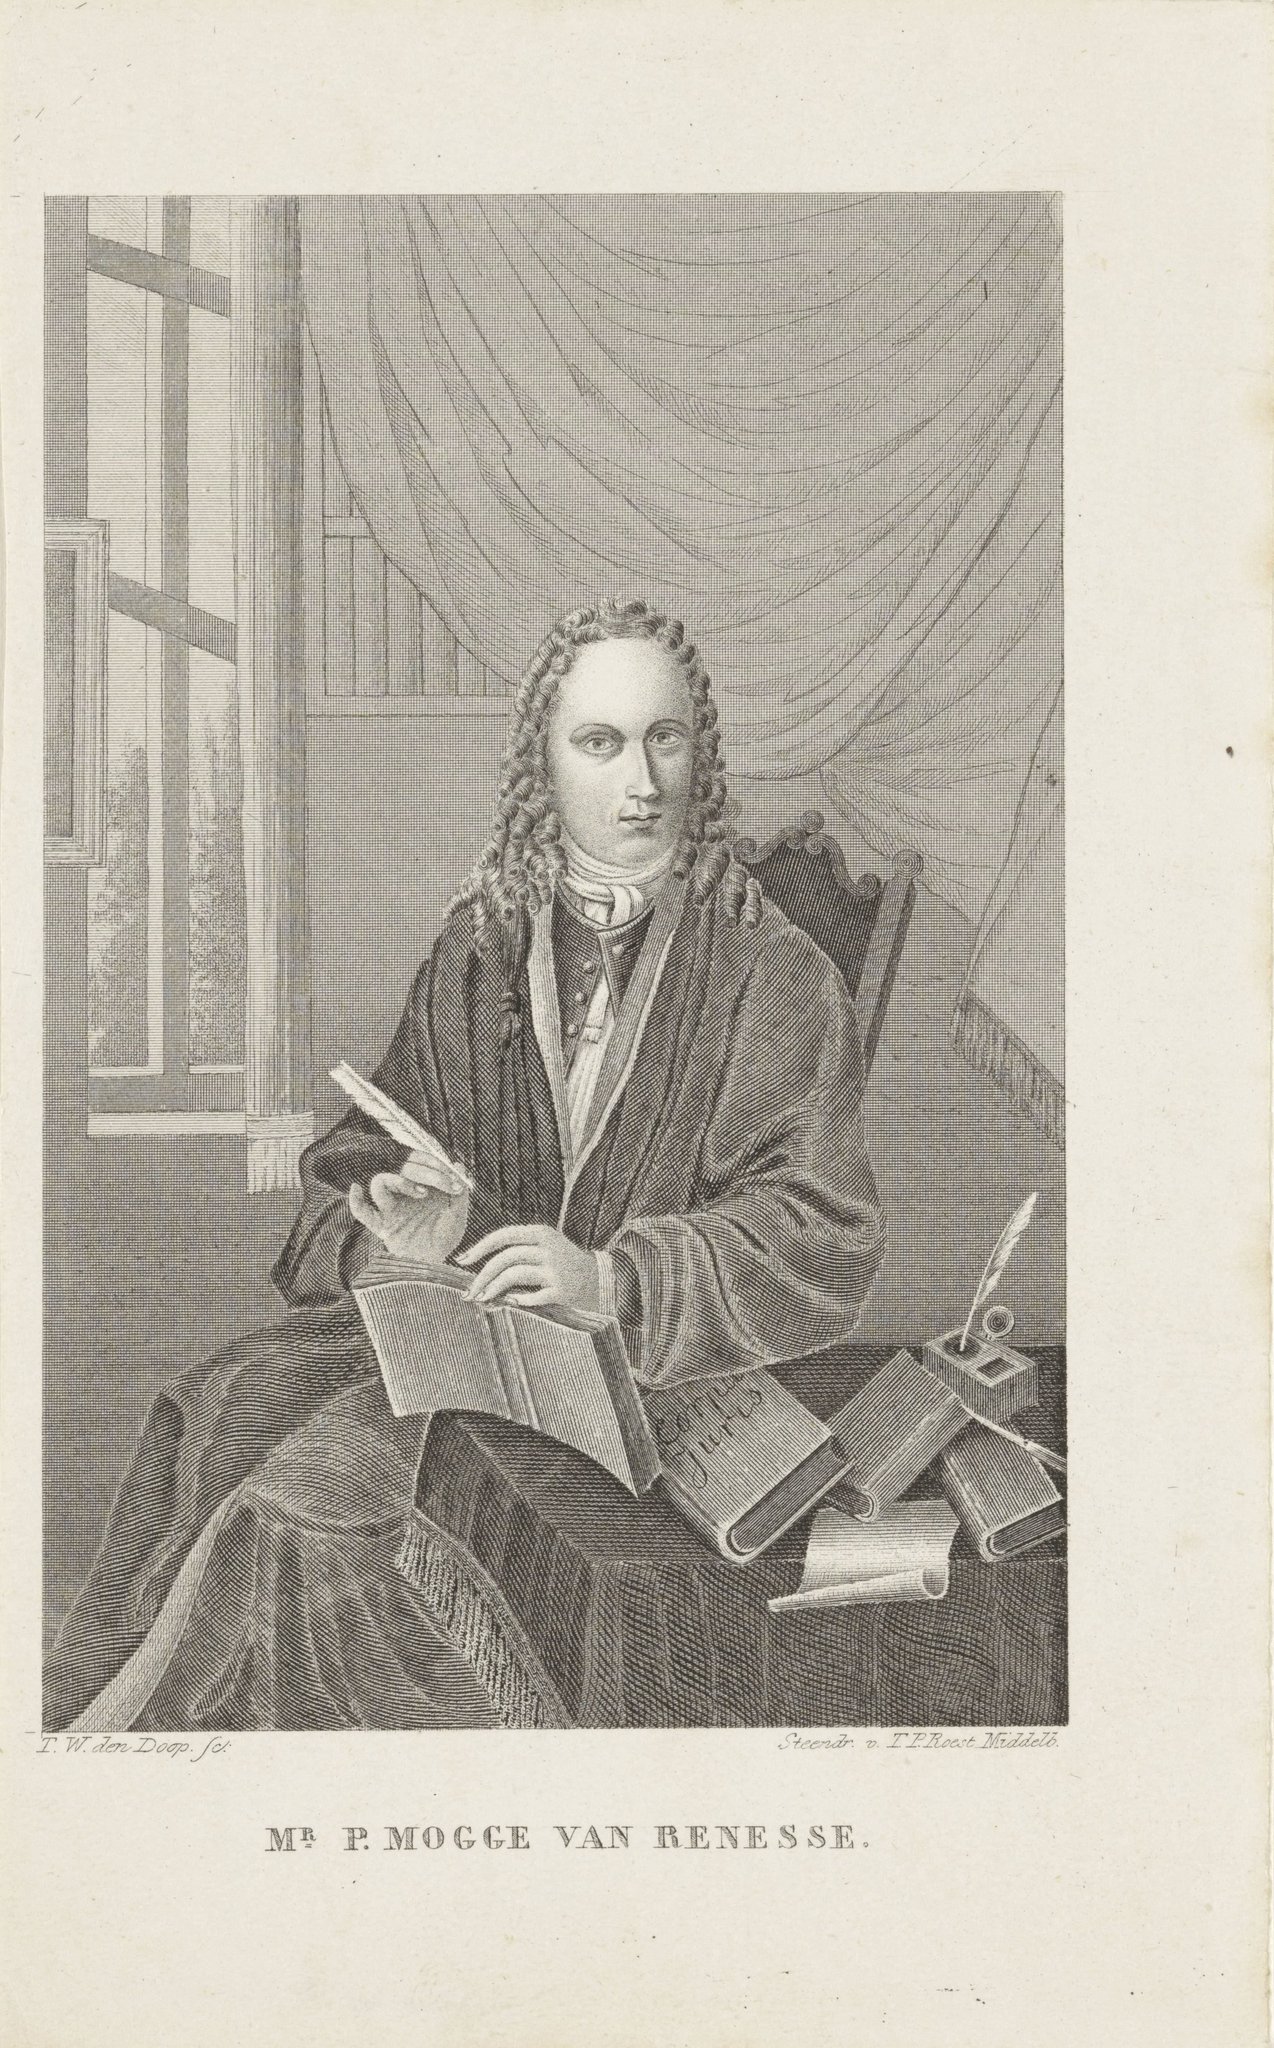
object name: print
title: Portret van burgemeester Pieter Mogge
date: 1829-1880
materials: paper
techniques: lithograph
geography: middelburg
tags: quill, book - mm - book open, historical persons (+ three-quarter length portrait)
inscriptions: collector's mark: Lugt 2228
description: De geportretteerde zit bij een raam naast een tafel met daarop boeken en schrijfgerei. In zijn linkerhand heeft hij een open boek, in zijn rechterhand een schrijfveer. Op een van de boeken staan de woorden: 'corpus iuris' wat verwijst naar Corpus Iuris Civilis, een verzameling wetten betreffende het burgerlijk recht.